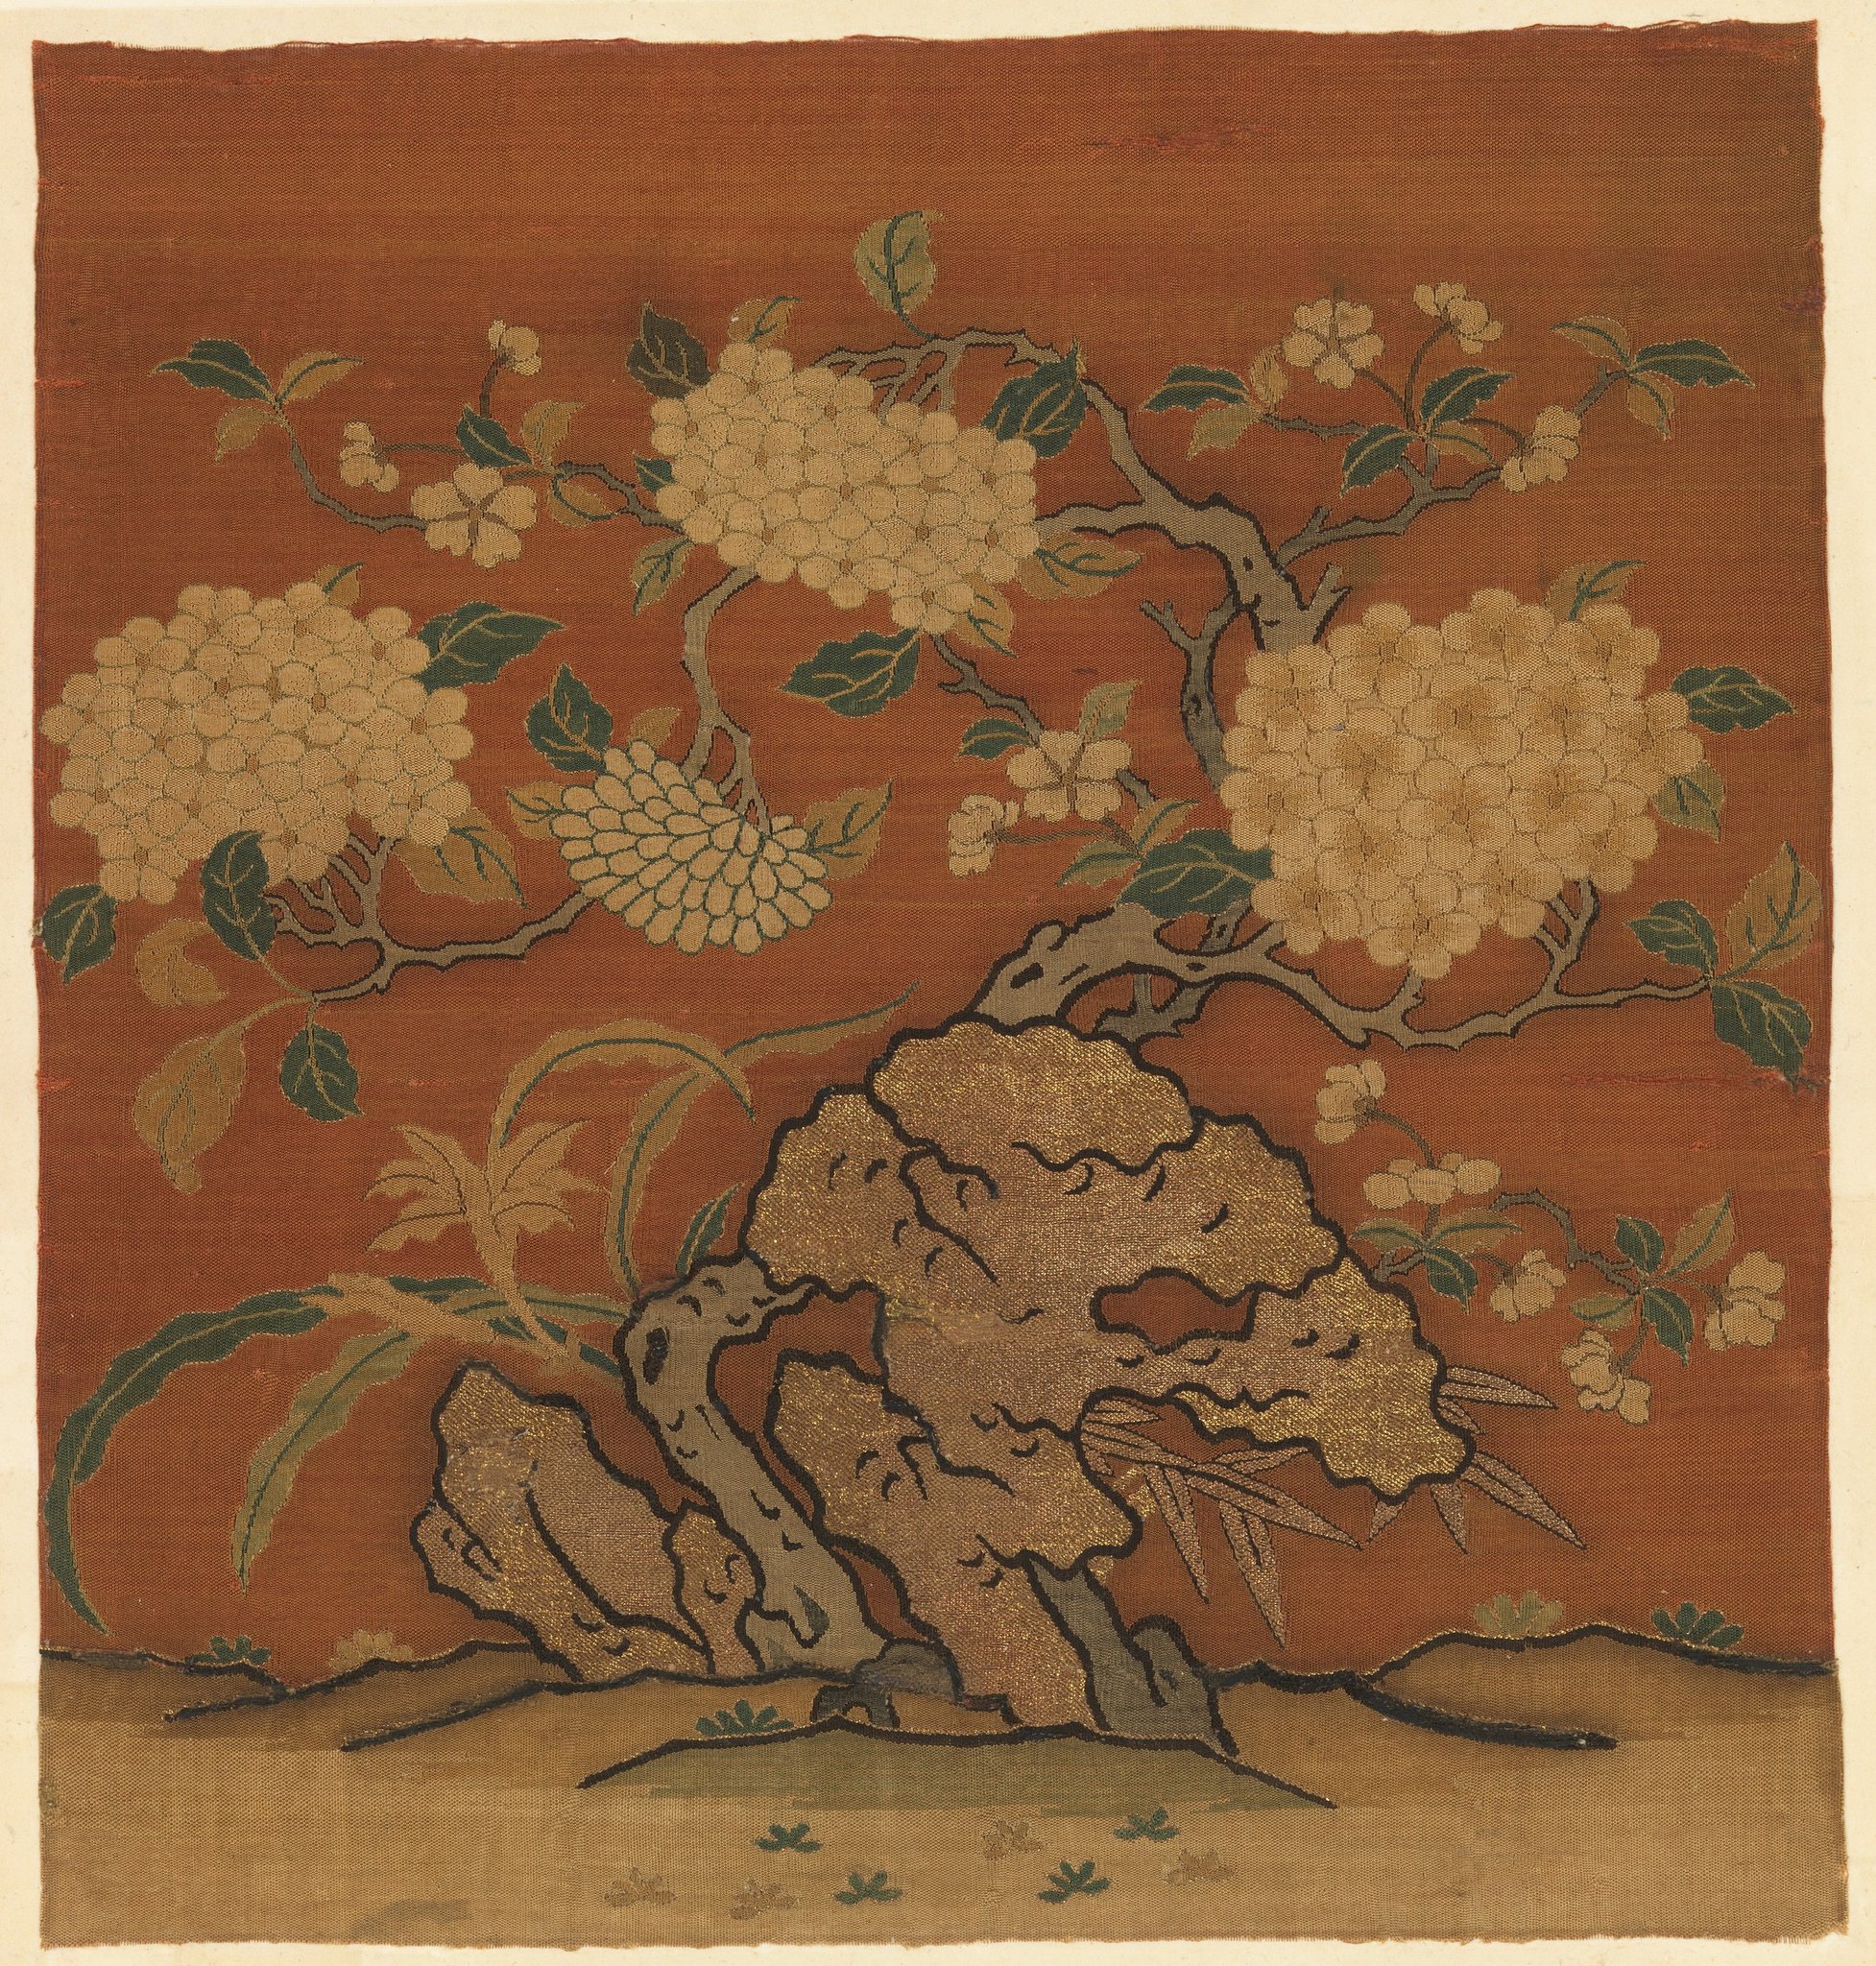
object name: panel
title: Flowers and Garden Rock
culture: chinese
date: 1301-1400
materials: metal thread, silk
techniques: tapestry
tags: flowers